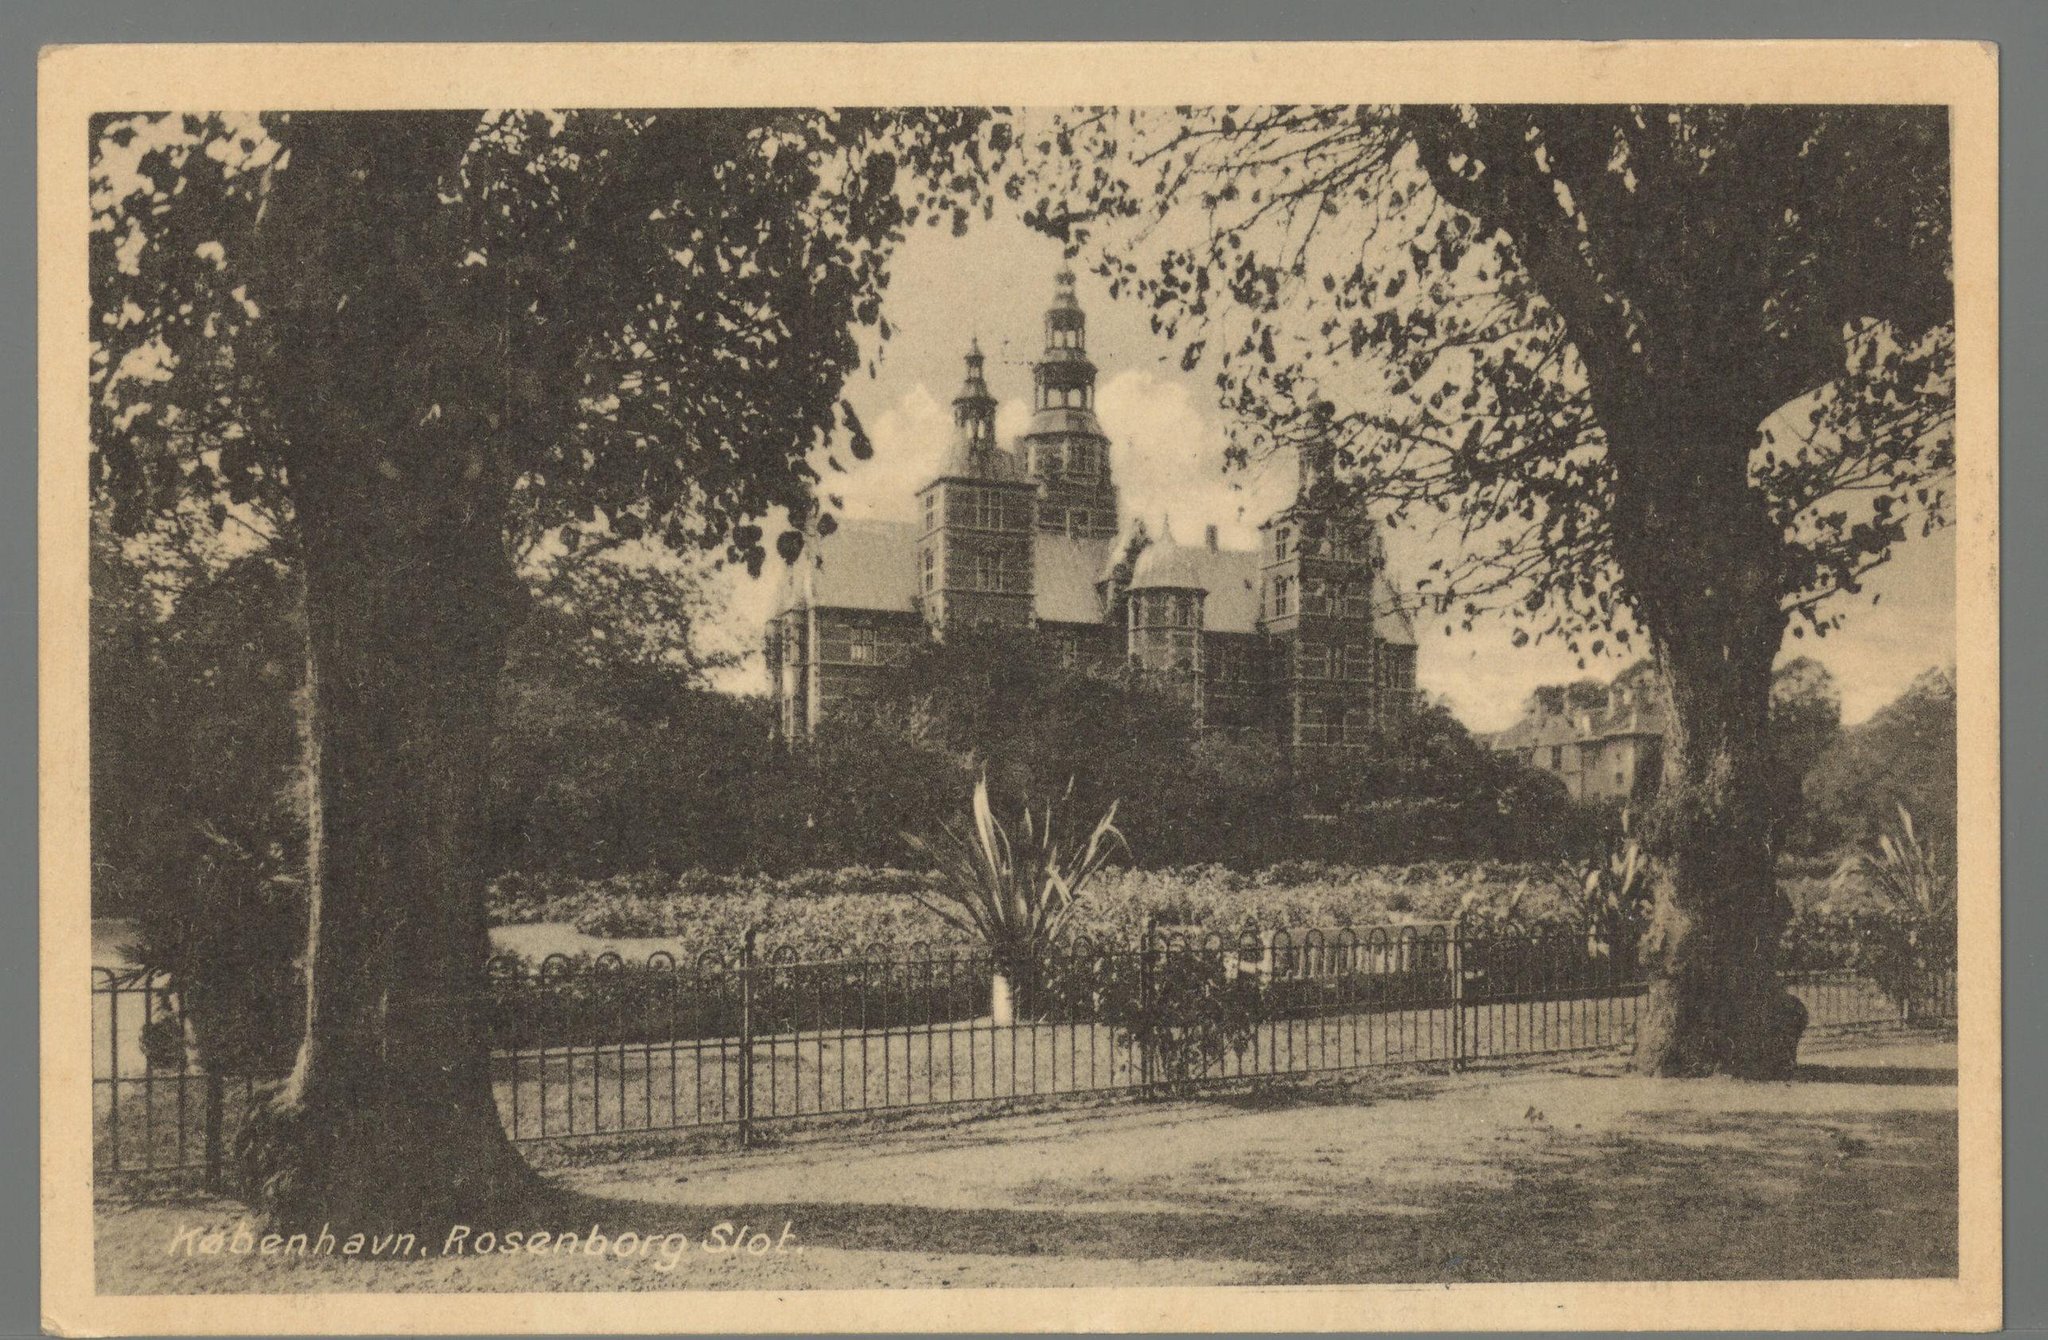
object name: ansichtkaart, prentbriefkaart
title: København, Rosenborg, Slot.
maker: Anonymous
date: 1870-1947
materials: cardboard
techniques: photograph, writing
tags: hôtel, i.e. small palace in city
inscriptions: postage stamp